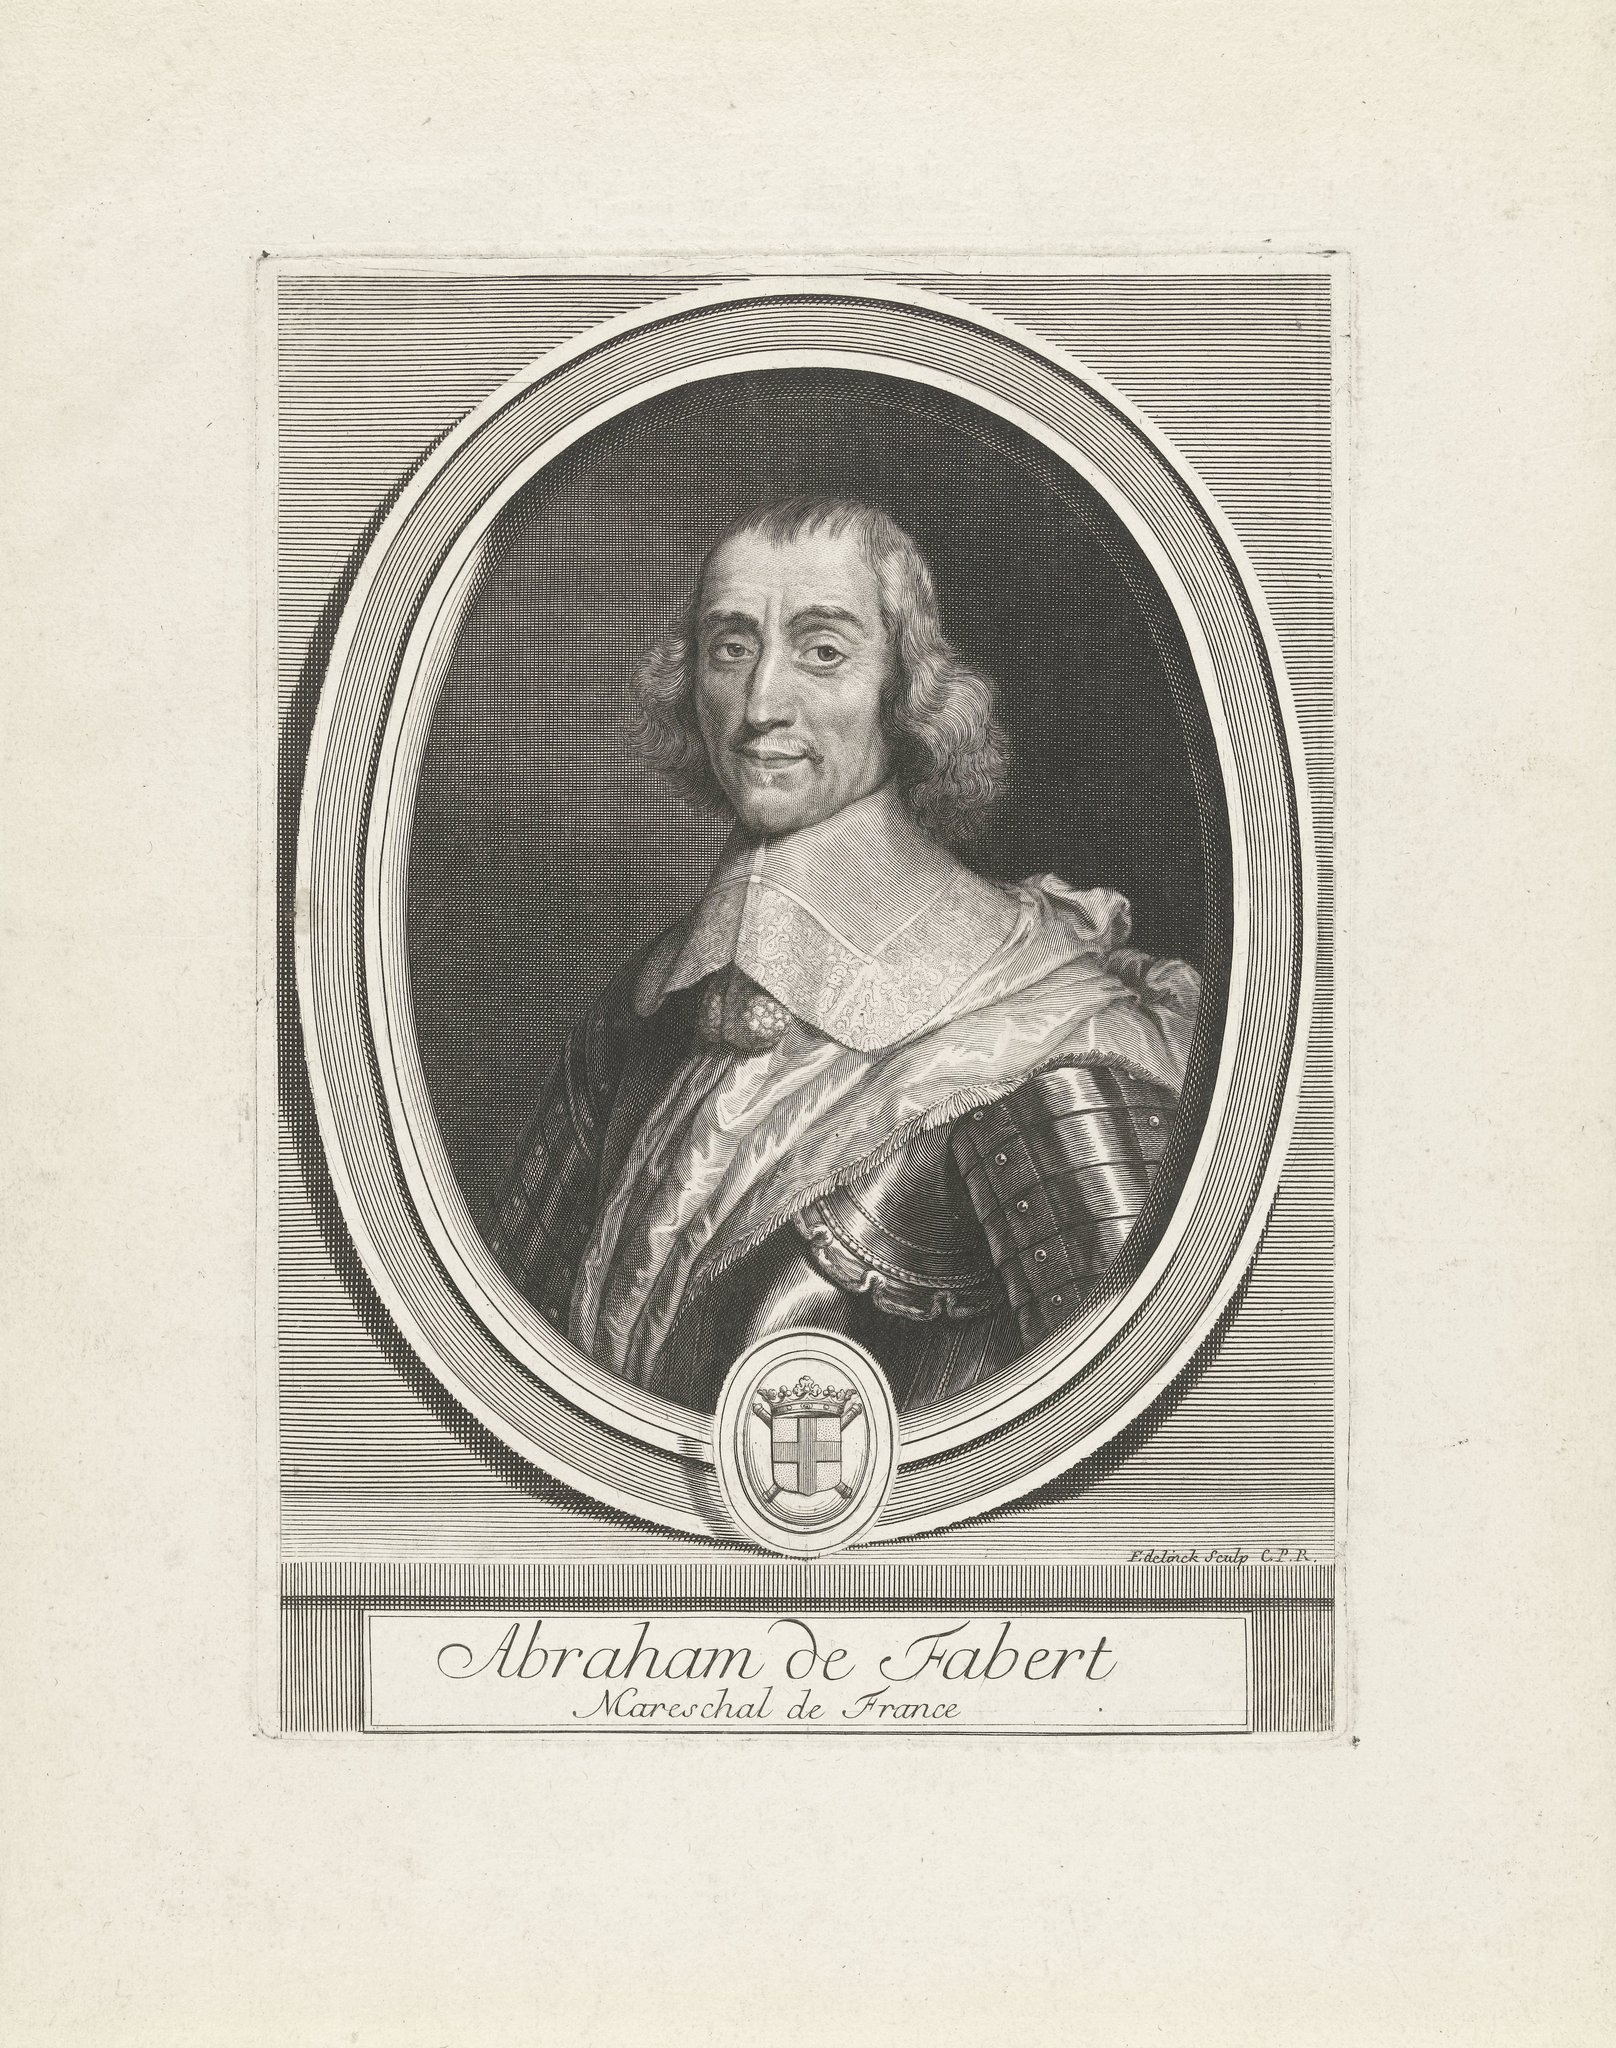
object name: print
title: Portret van Abraham de Fabert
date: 1666-1707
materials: paper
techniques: engraving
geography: paris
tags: maarschalk, abraham de fabert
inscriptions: collector's mark: Lugt 240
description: Portret van maarschalk Abraham de Fabert (1599-1660), afgebeeld in ovale omlijsting met wapen.